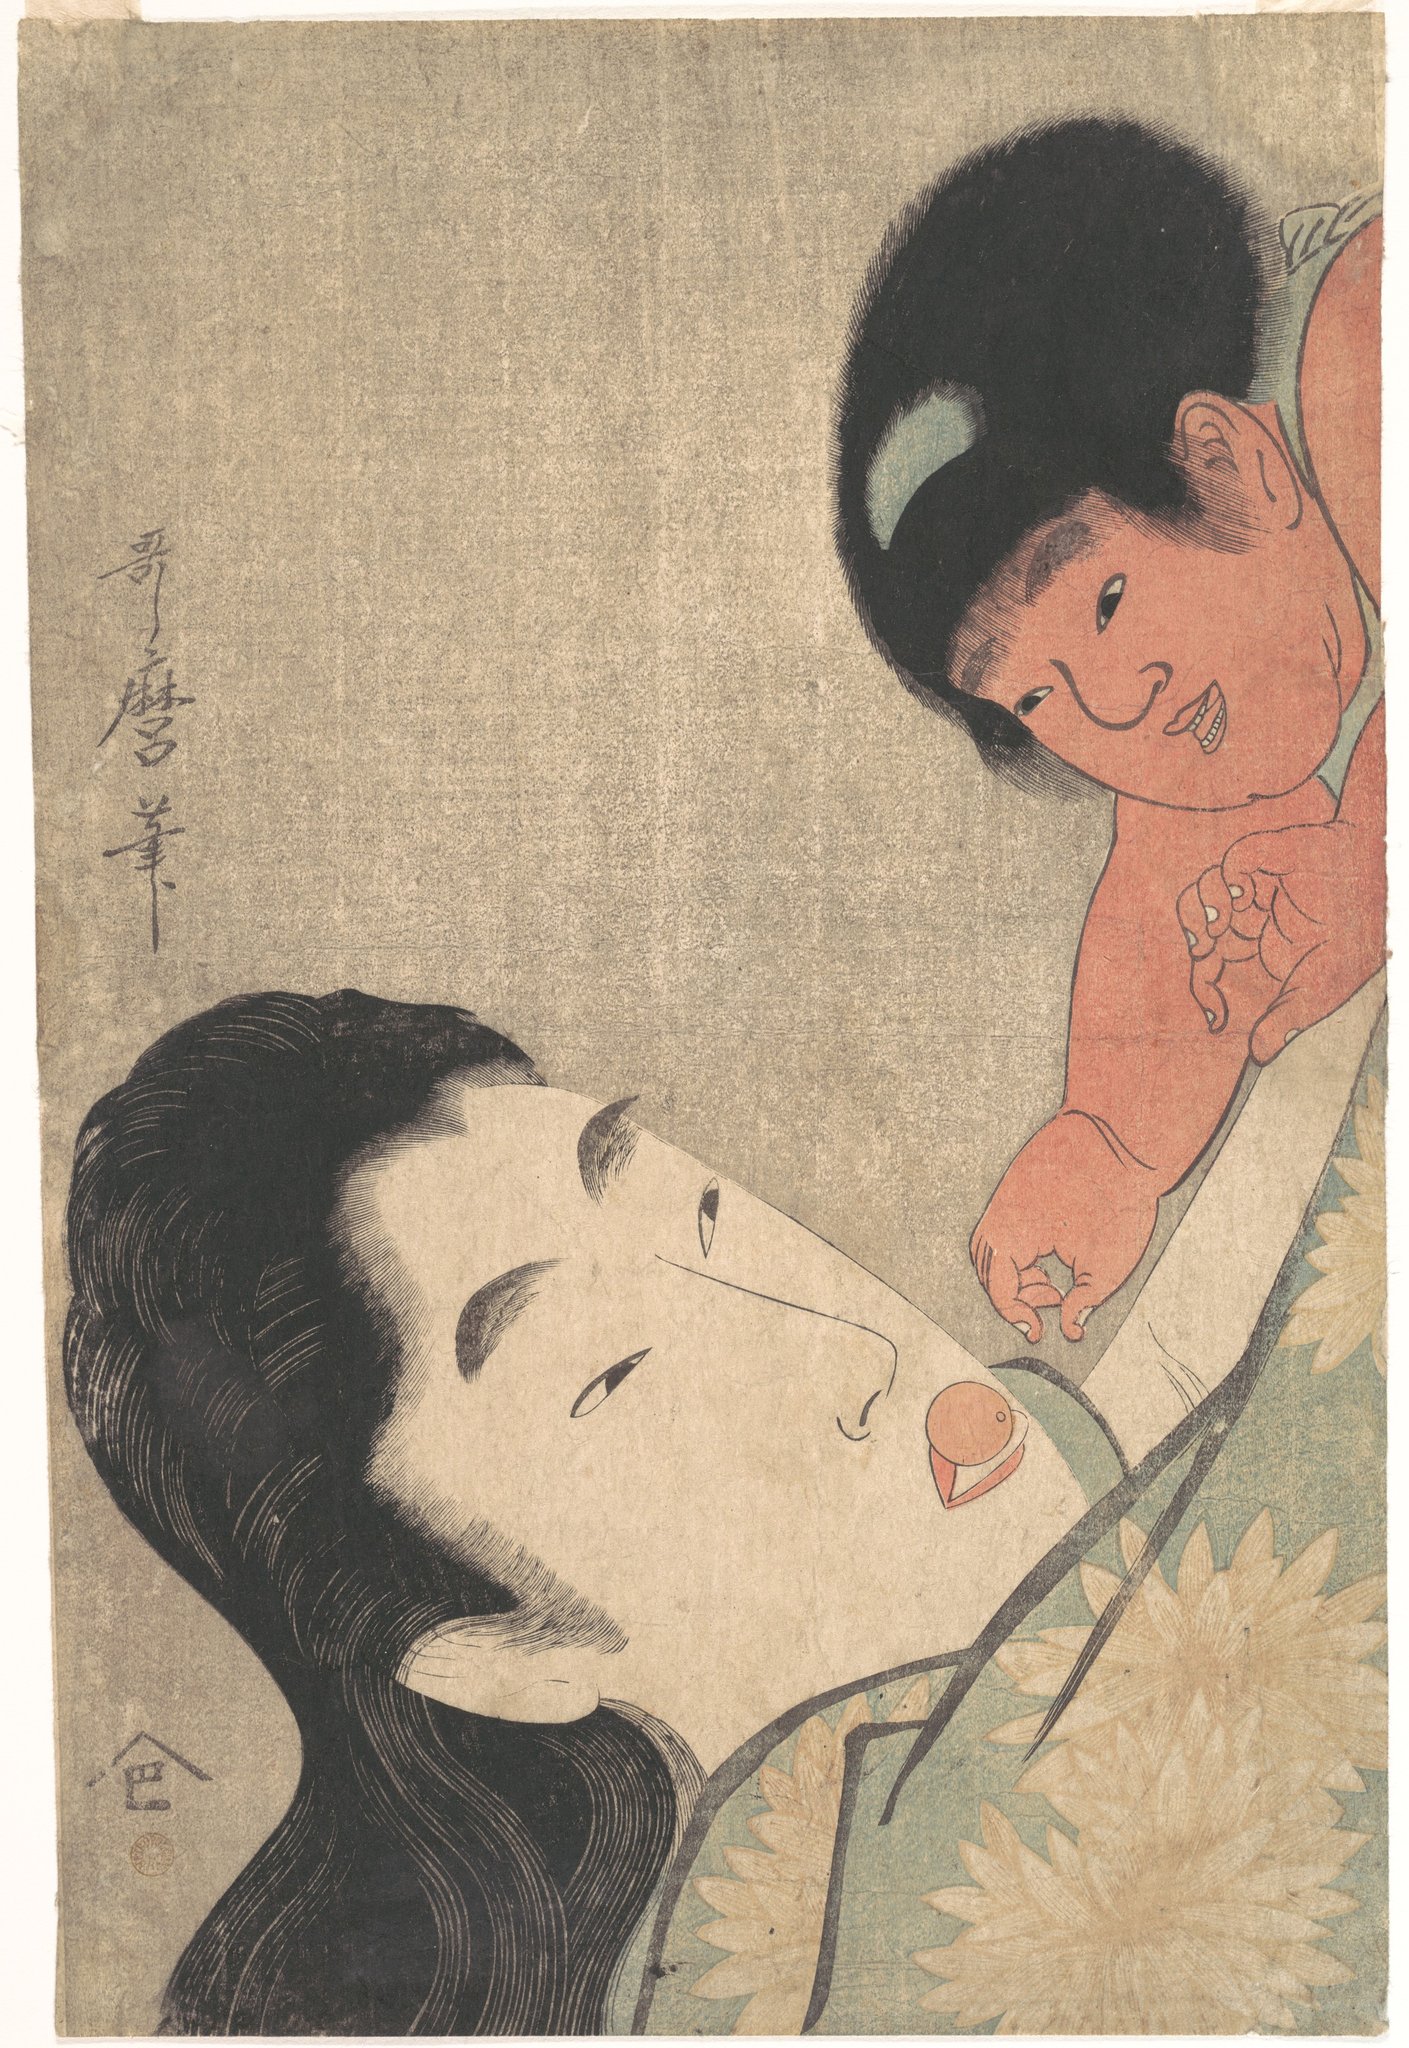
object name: print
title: Yamauba and Kintarō Playing with a Cherry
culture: japanese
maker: kitagawa utamaro 喜多川歌麿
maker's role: artist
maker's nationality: japanese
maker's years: 1754-1806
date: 1795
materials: ink, paper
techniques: nishiki e, woodblock print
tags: children,women